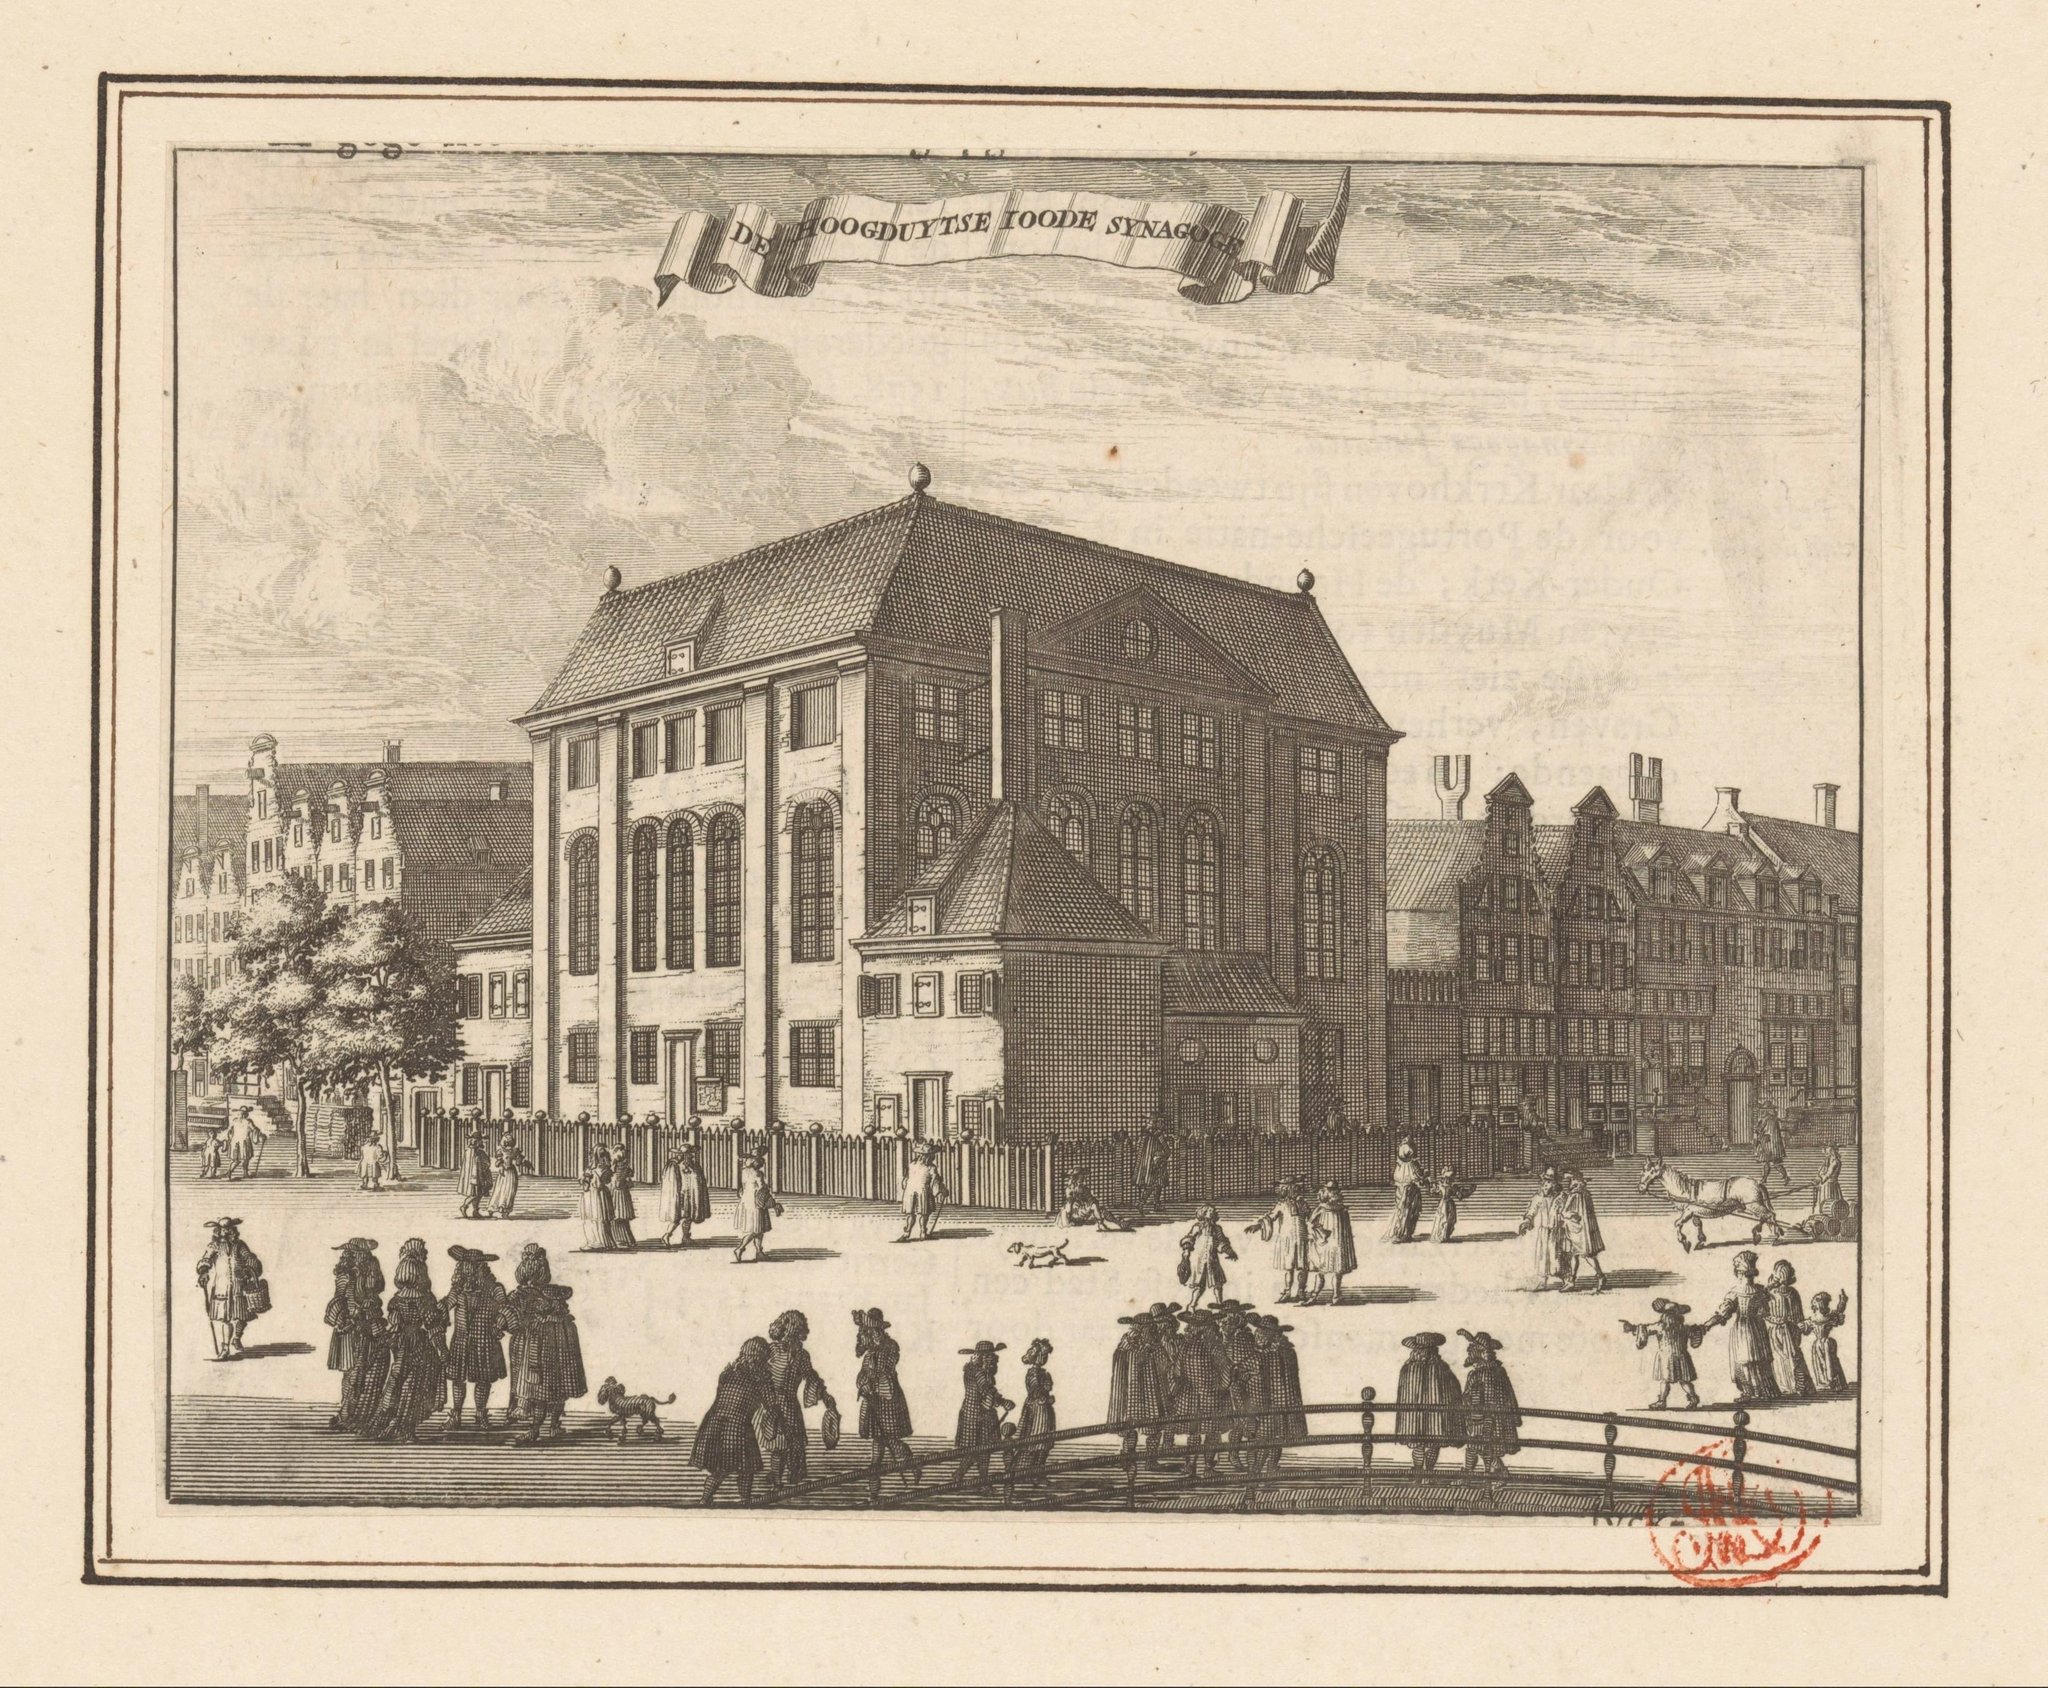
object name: book illustration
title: Gezicht op de Grote Synagoge te Amsterdam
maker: Anonymous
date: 1693-1694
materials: paper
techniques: engraving, etching, letterpress printing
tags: 'ashkenazim' ~ jewish communities, the synagogue (as building and place of worship ~ jewish religion), street (+ city(-scape) with figures, staffage)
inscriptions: collector's mark: Lugt 195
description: Prent gebruikt in: Commelin, Caspar. Beschryvinge van Amsterdam, desselfs eerste oorspronk uyt den Huyse (…). 2 delen. Amsterdam: Abraham Wolfgang, Gillis Janssonius van Waesberge, Johannes Janssonius van Waesberge II, weduwe Dirk Boom I, Hendrick Boom en Rembertus Goethals, 1693. Of in: Commelin, Caspar. Beschryvinge van Amsterdam, zynde een naukeurige verhandelinge van desselfs eerste oorspronk uyt (…). 2 delen. Amsterdam: weduwe Aart Dircksz Oossaan, 1694. Latere staat ook gebruikt in: Commelin, Caspar. Beschryvinge van Amsterdam, zynde een naukeurige verhandelinge van desselfs eerste oorspronk uyt (…). 2 delen. 2e druk. Amsterdam: Andries van Damme, Johannes Ratelband, weduwe A. van Aaltwyk en Hermanus Uytwerf, 1726. Boven en onder kleine stukjes van tekst in boekdruk zichtbaar.